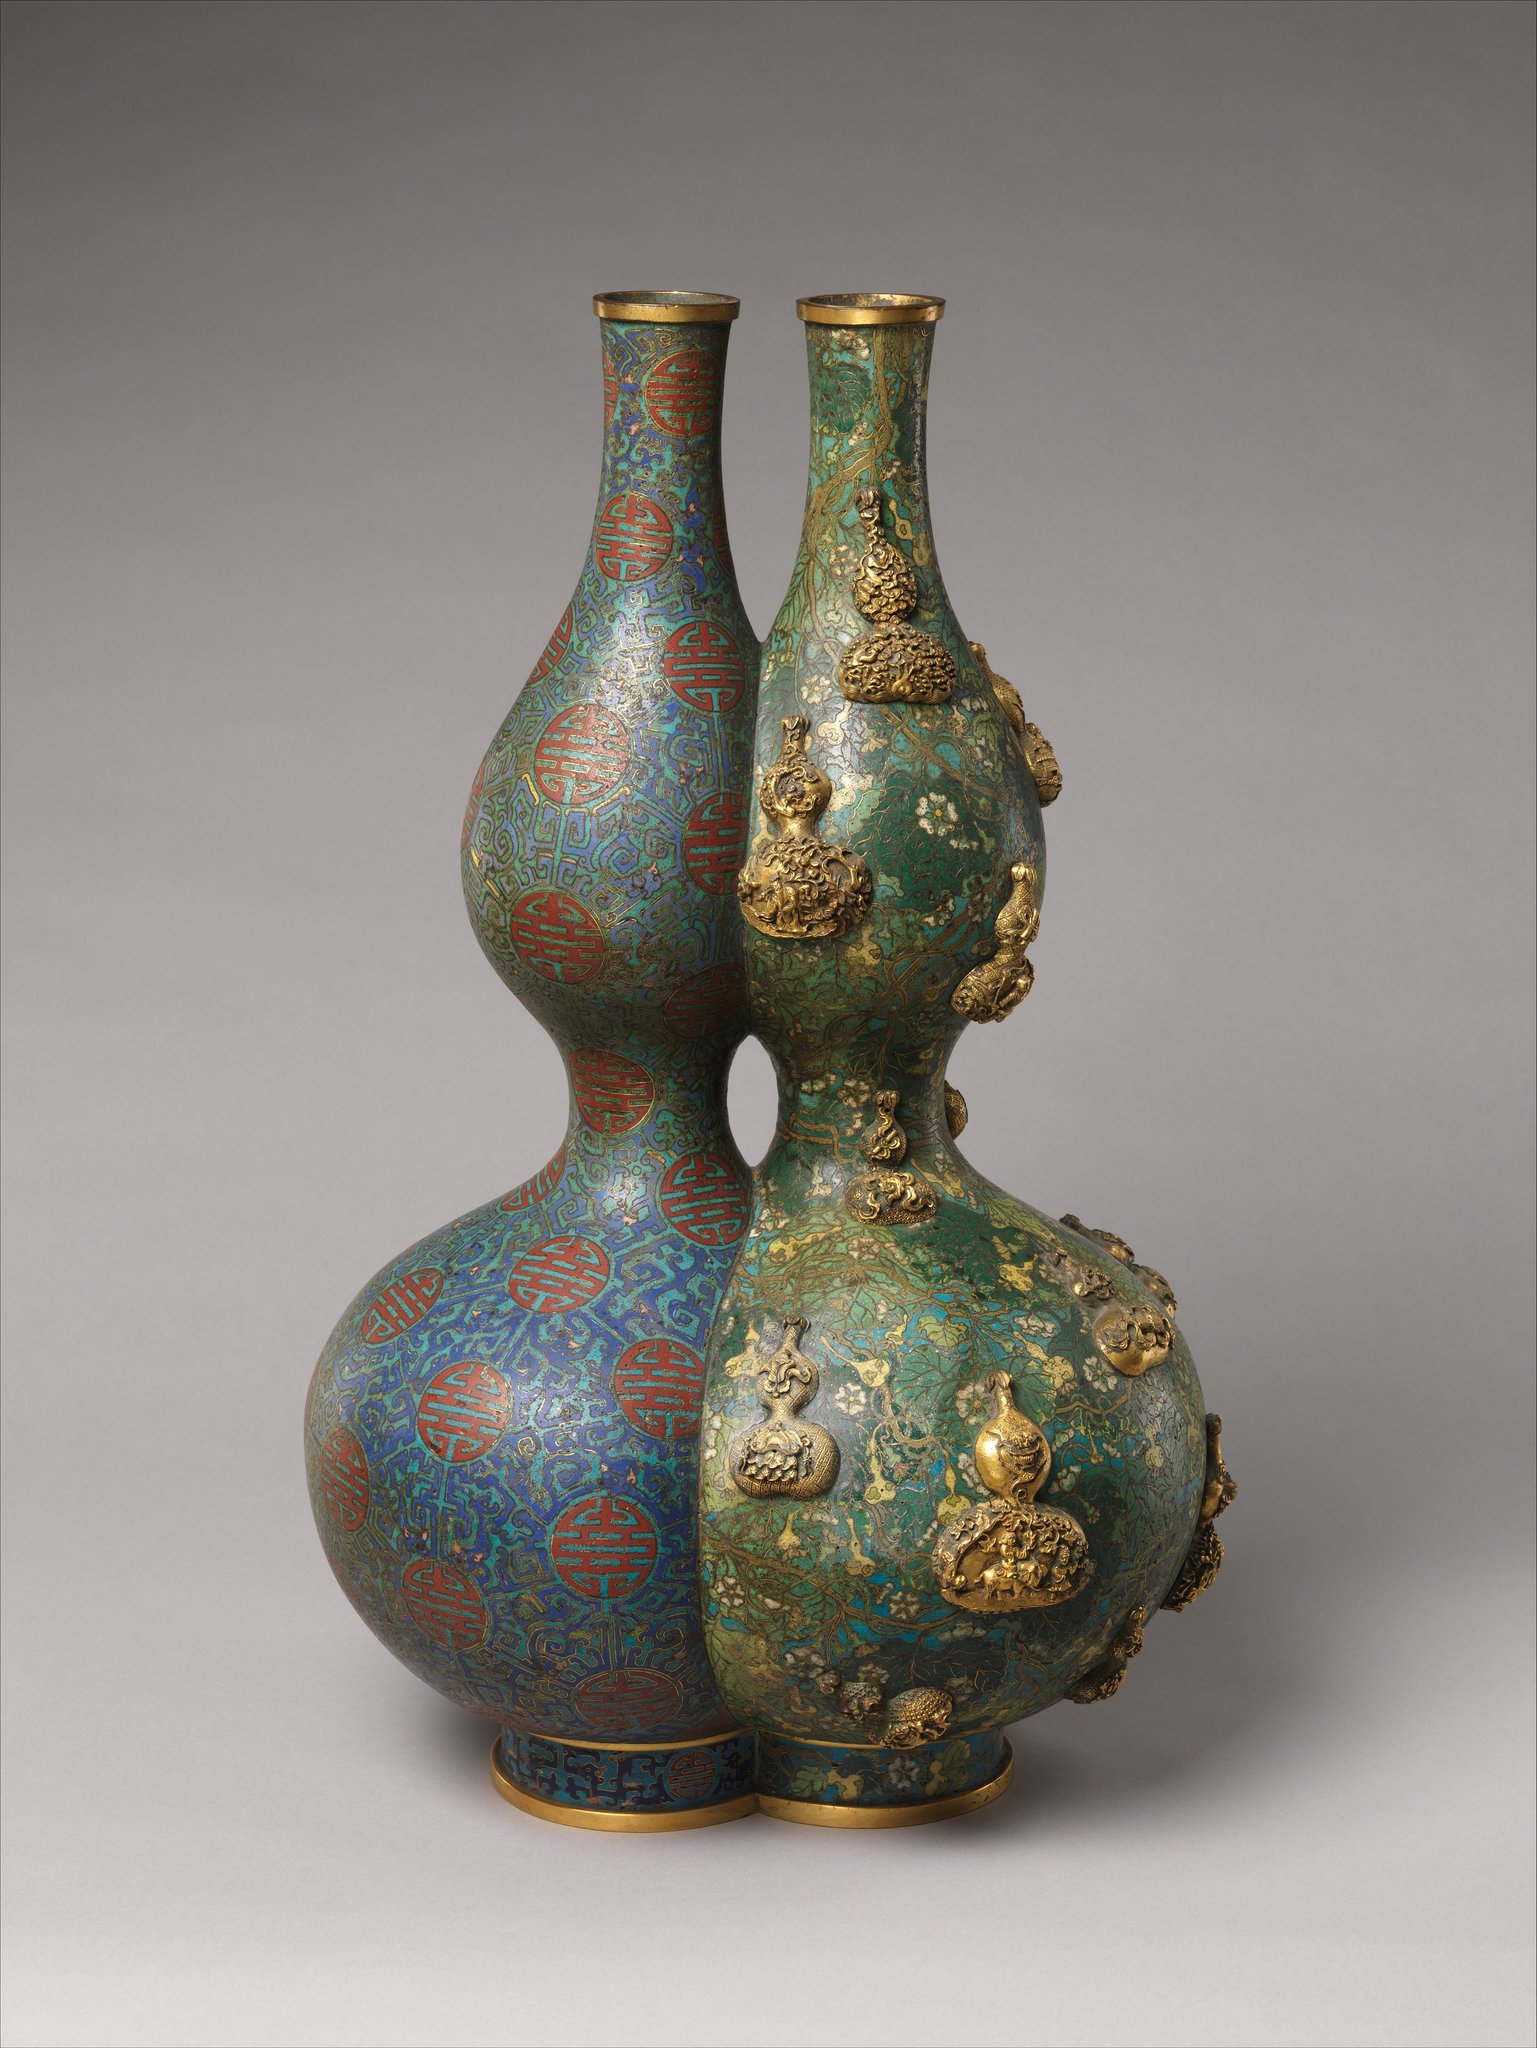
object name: double vase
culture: chinese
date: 1662-1722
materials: copper, enamel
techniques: enamel